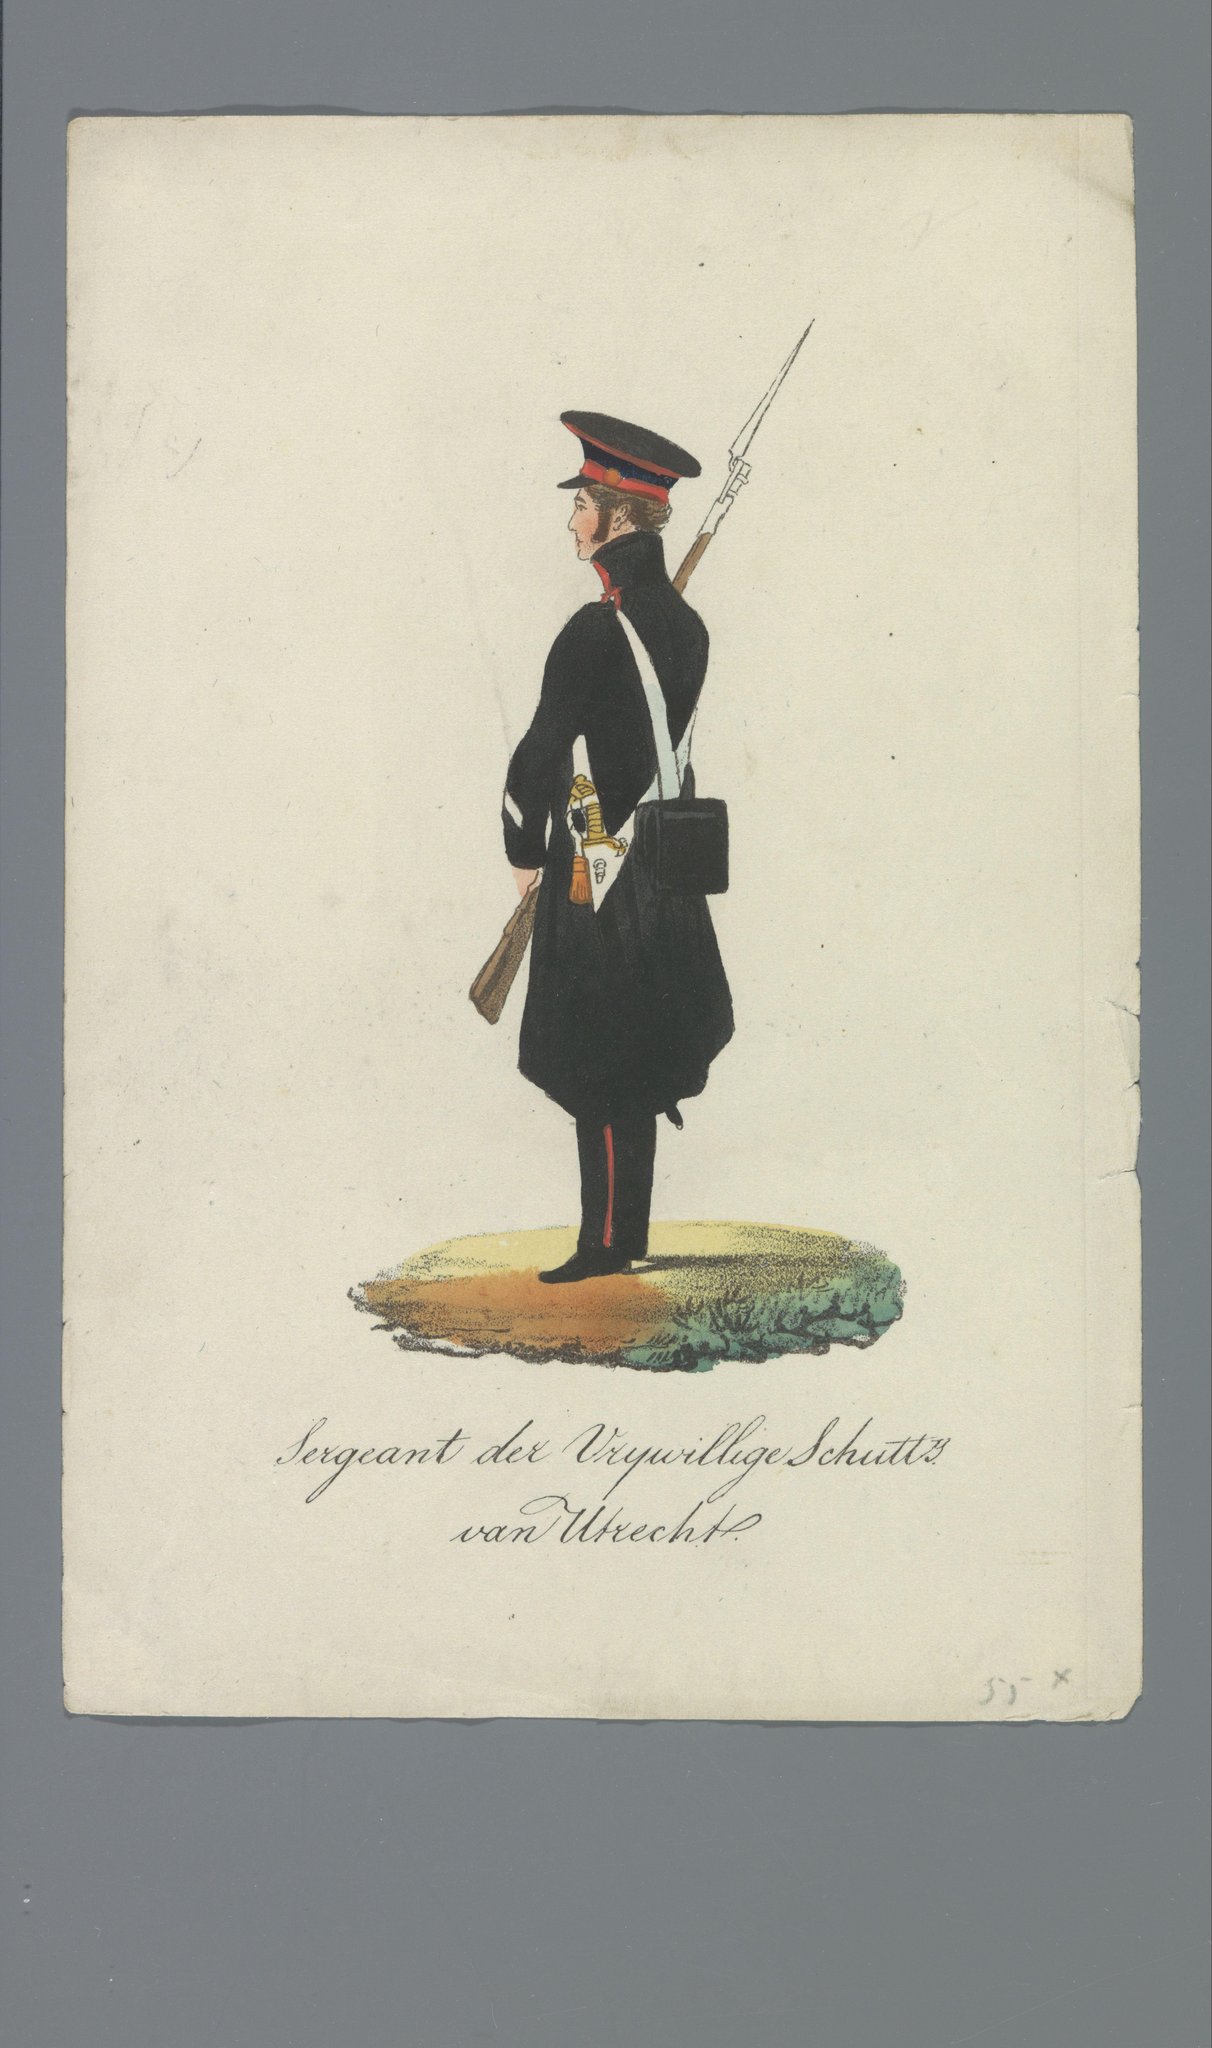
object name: print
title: Nederlandse militaire uniformen in de jaren 1830-1832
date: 1835-1850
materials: paper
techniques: hand coloring, lithograph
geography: netherlands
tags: (military) uniforms, clothes, costume, utrecht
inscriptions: collector's mark: Lugt 2228, collector's mark: Lugt 2227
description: Staande sergeant van de Afdeling Utrechtse Schutterij. Onderdeel van een serie van 157 losse bladen met Nederlandse militaire uniformen in de jaren 1830-1832.